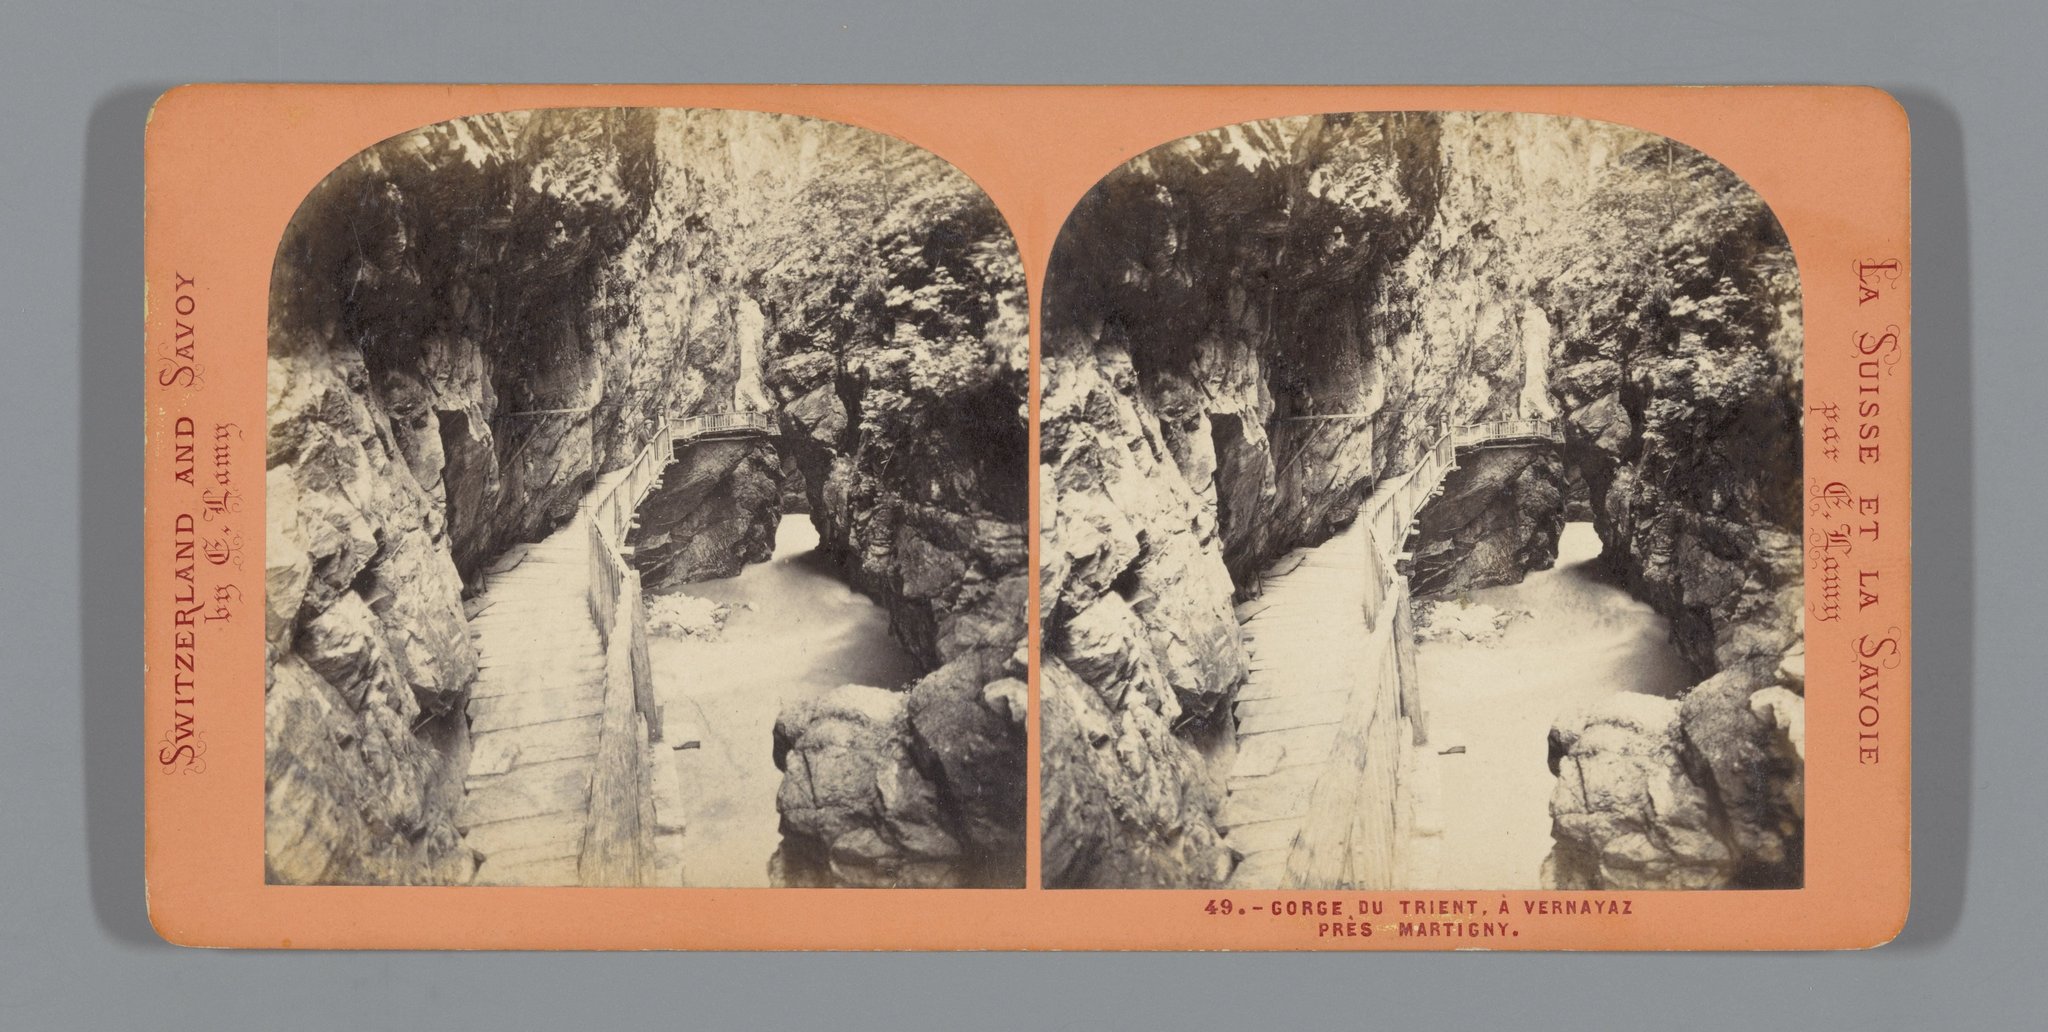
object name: stereograph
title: La Suisse et la Savoie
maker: ernest eléonor pierre lamy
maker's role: publisher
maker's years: 1828-1900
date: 1860-1880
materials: cardboard, photographic support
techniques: albumen print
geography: switzerland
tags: ravine, chasm, abyss, canyon, public road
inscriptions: number: ‘49.’